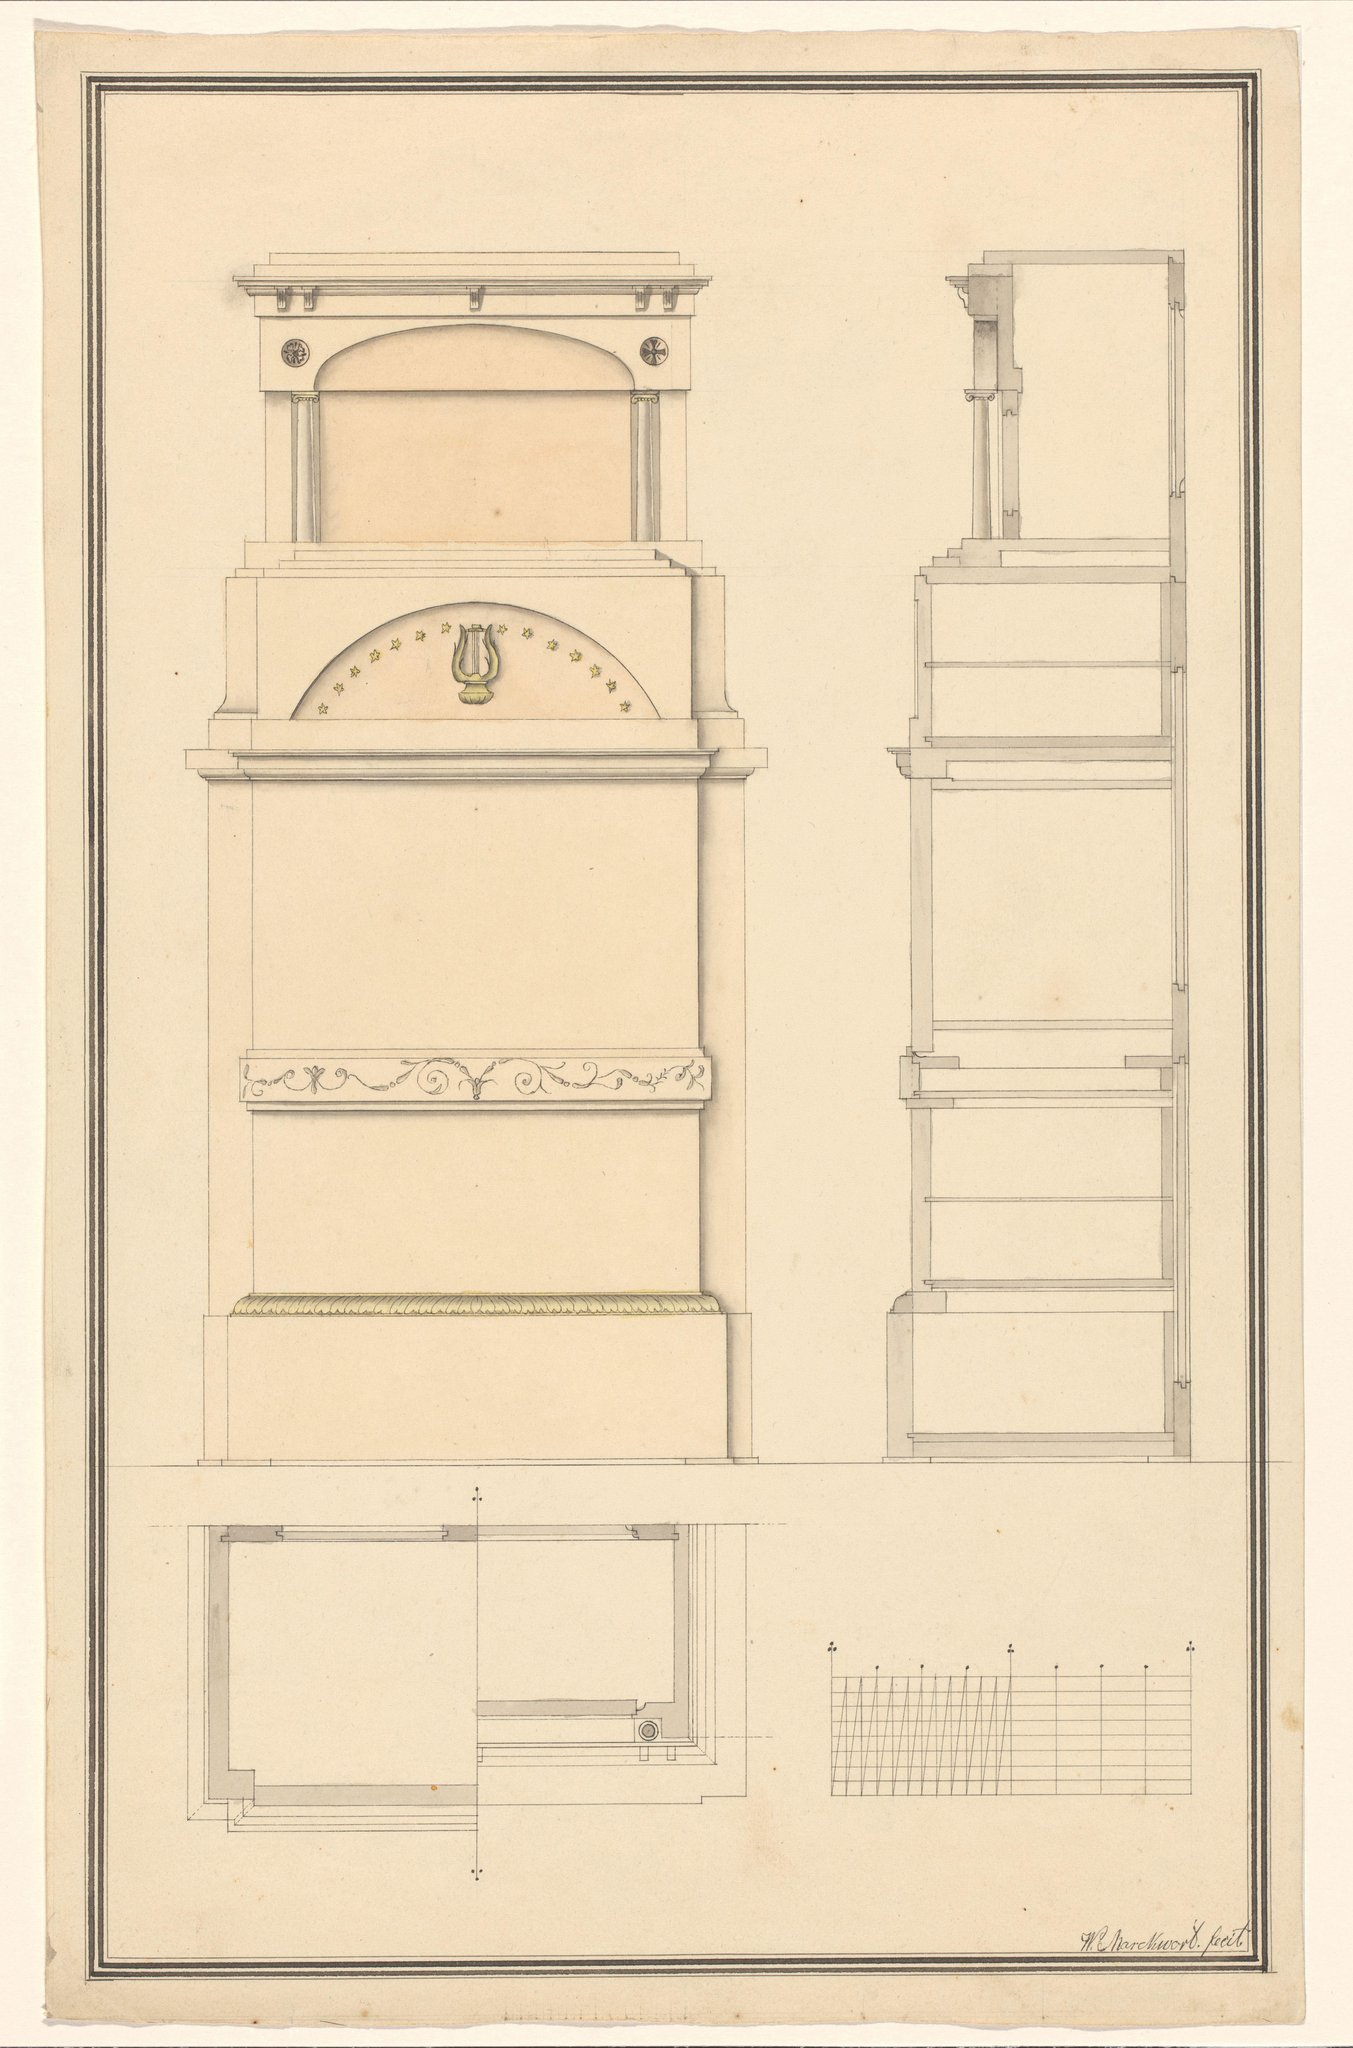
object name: design drawing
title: Ontwerp voor een secretaire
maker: carl wilhelm marckwort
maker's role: draughtsman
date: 1820-1823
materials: ink, paper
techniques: brush, pen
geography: berlin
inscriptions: signature: ‘W.C. Marckwort. fecit.’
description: Goudkleurige lier te midden van sterren, voor- en zijaanzicht, met daaronder een in tweeën gedeelde plattegrond en een maatverdeling.